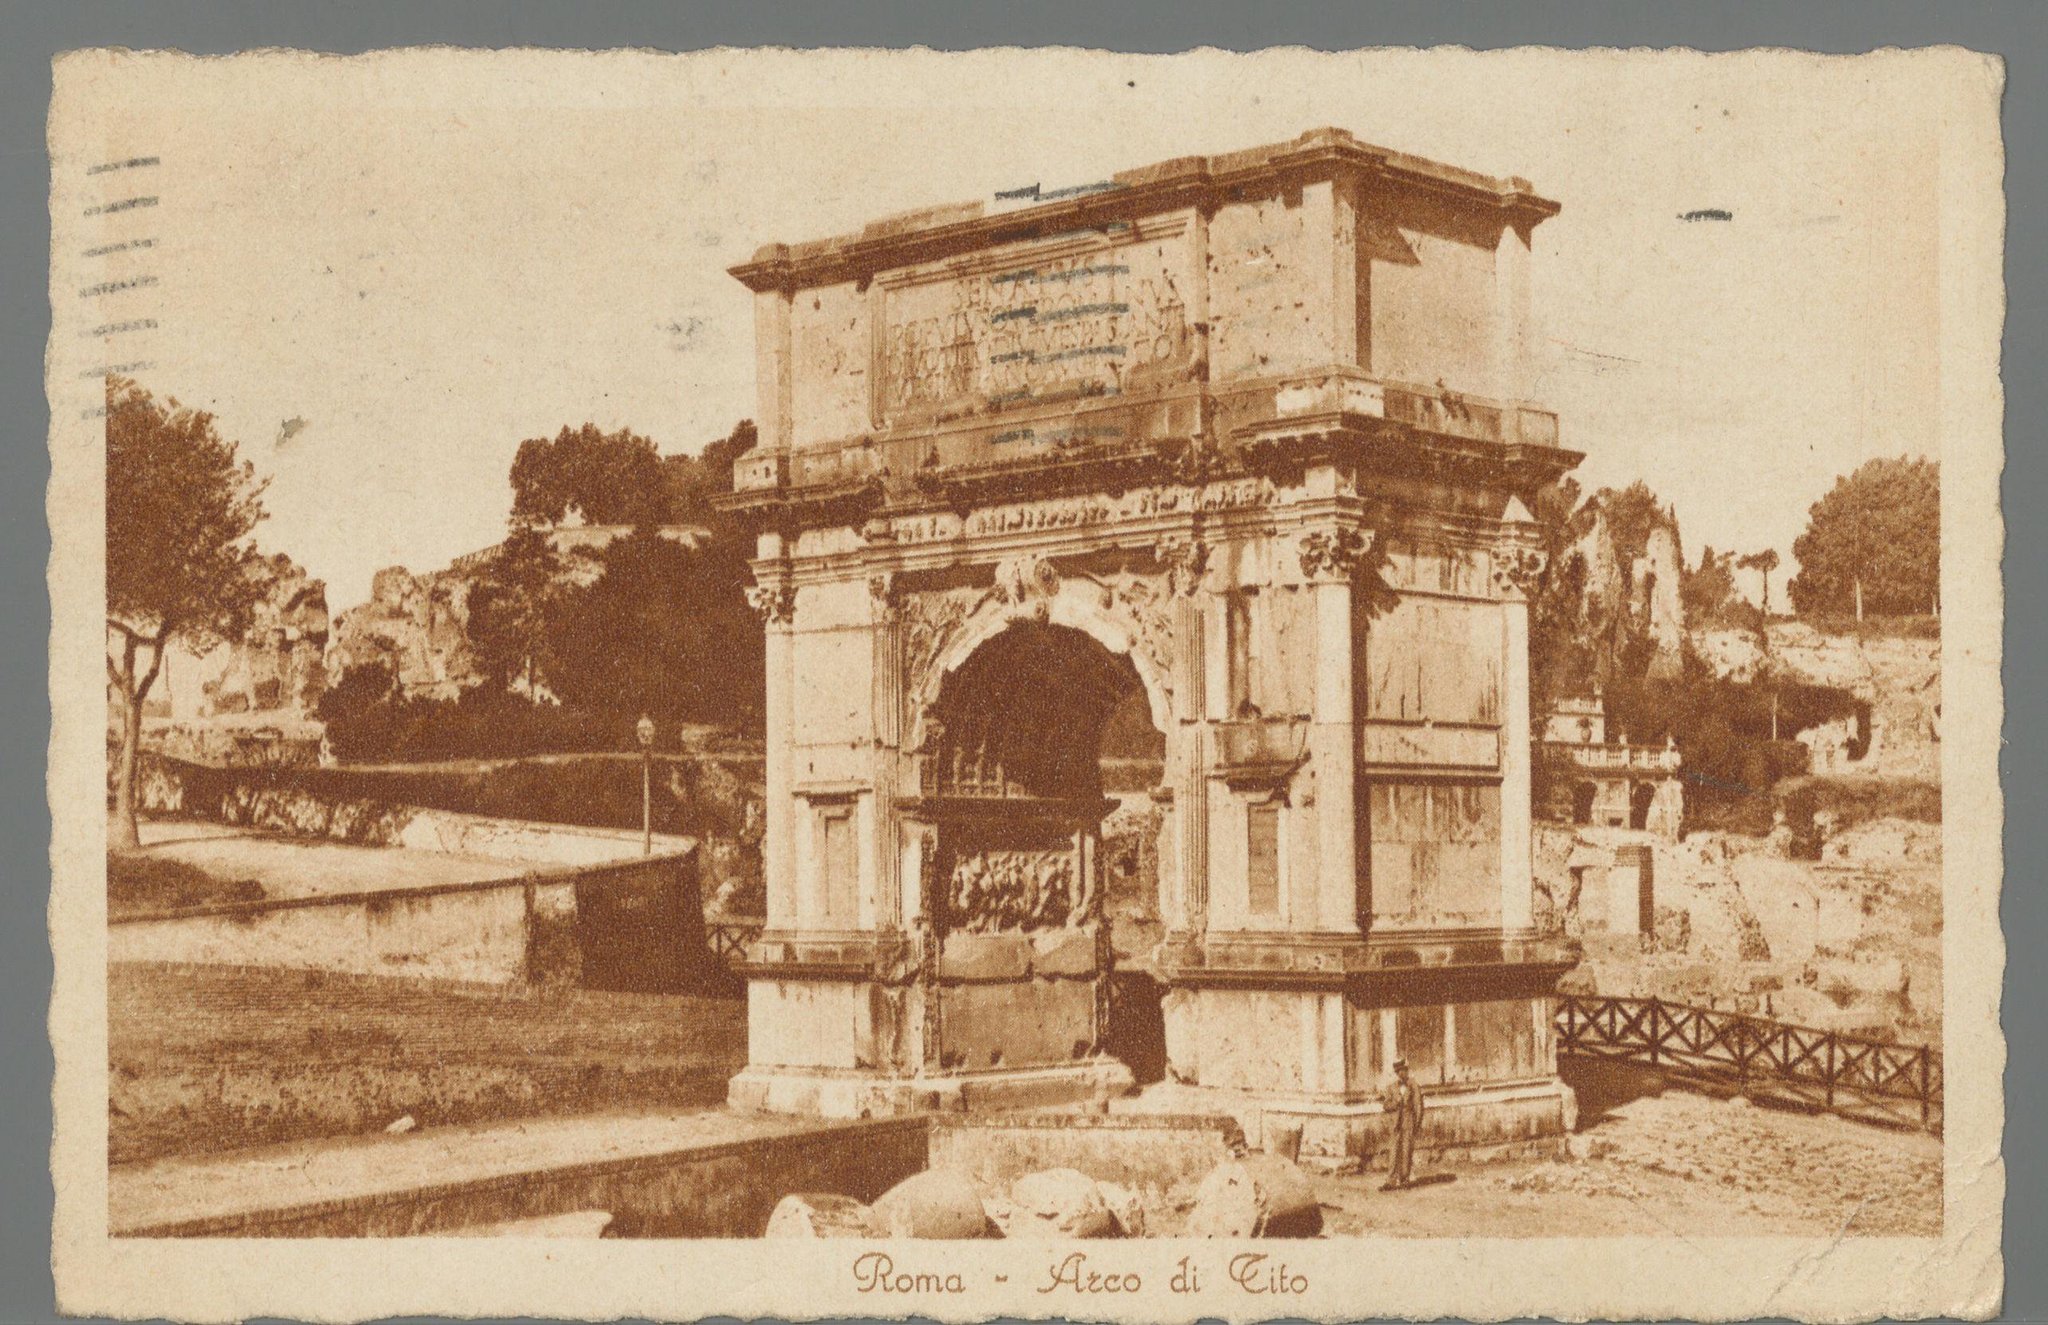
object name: photomechanical print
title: Roma. Arco di Tito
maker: Anonymous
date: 1906-1932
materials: cardboard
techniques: rotogravure, writing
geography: milan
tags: triumphal arch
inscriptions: postage stamp